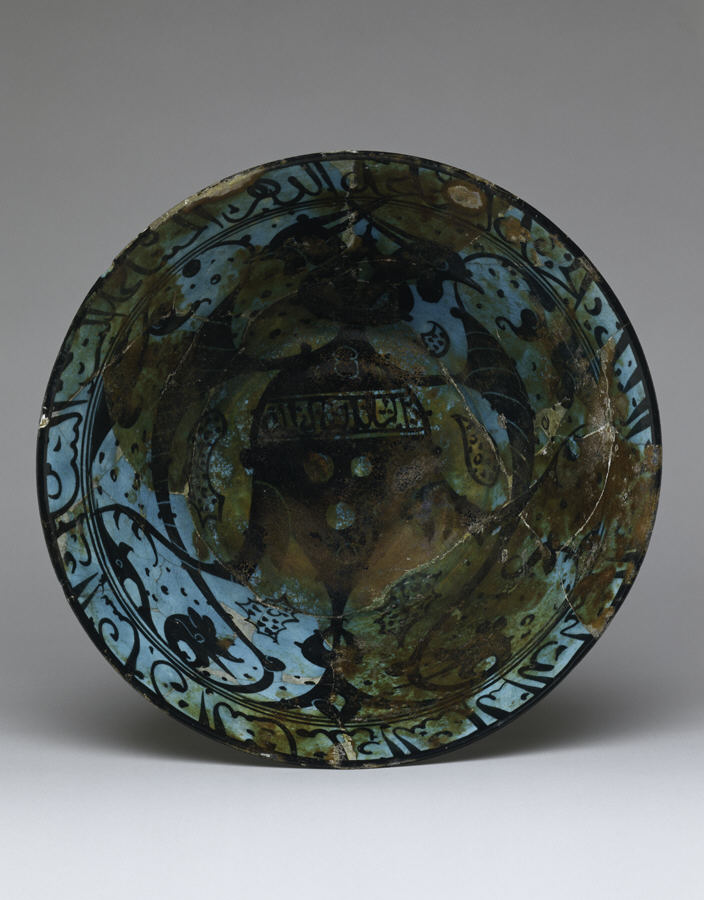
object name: bowl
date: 1167-1233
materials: glaze, stonepaste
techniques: painting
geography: syria